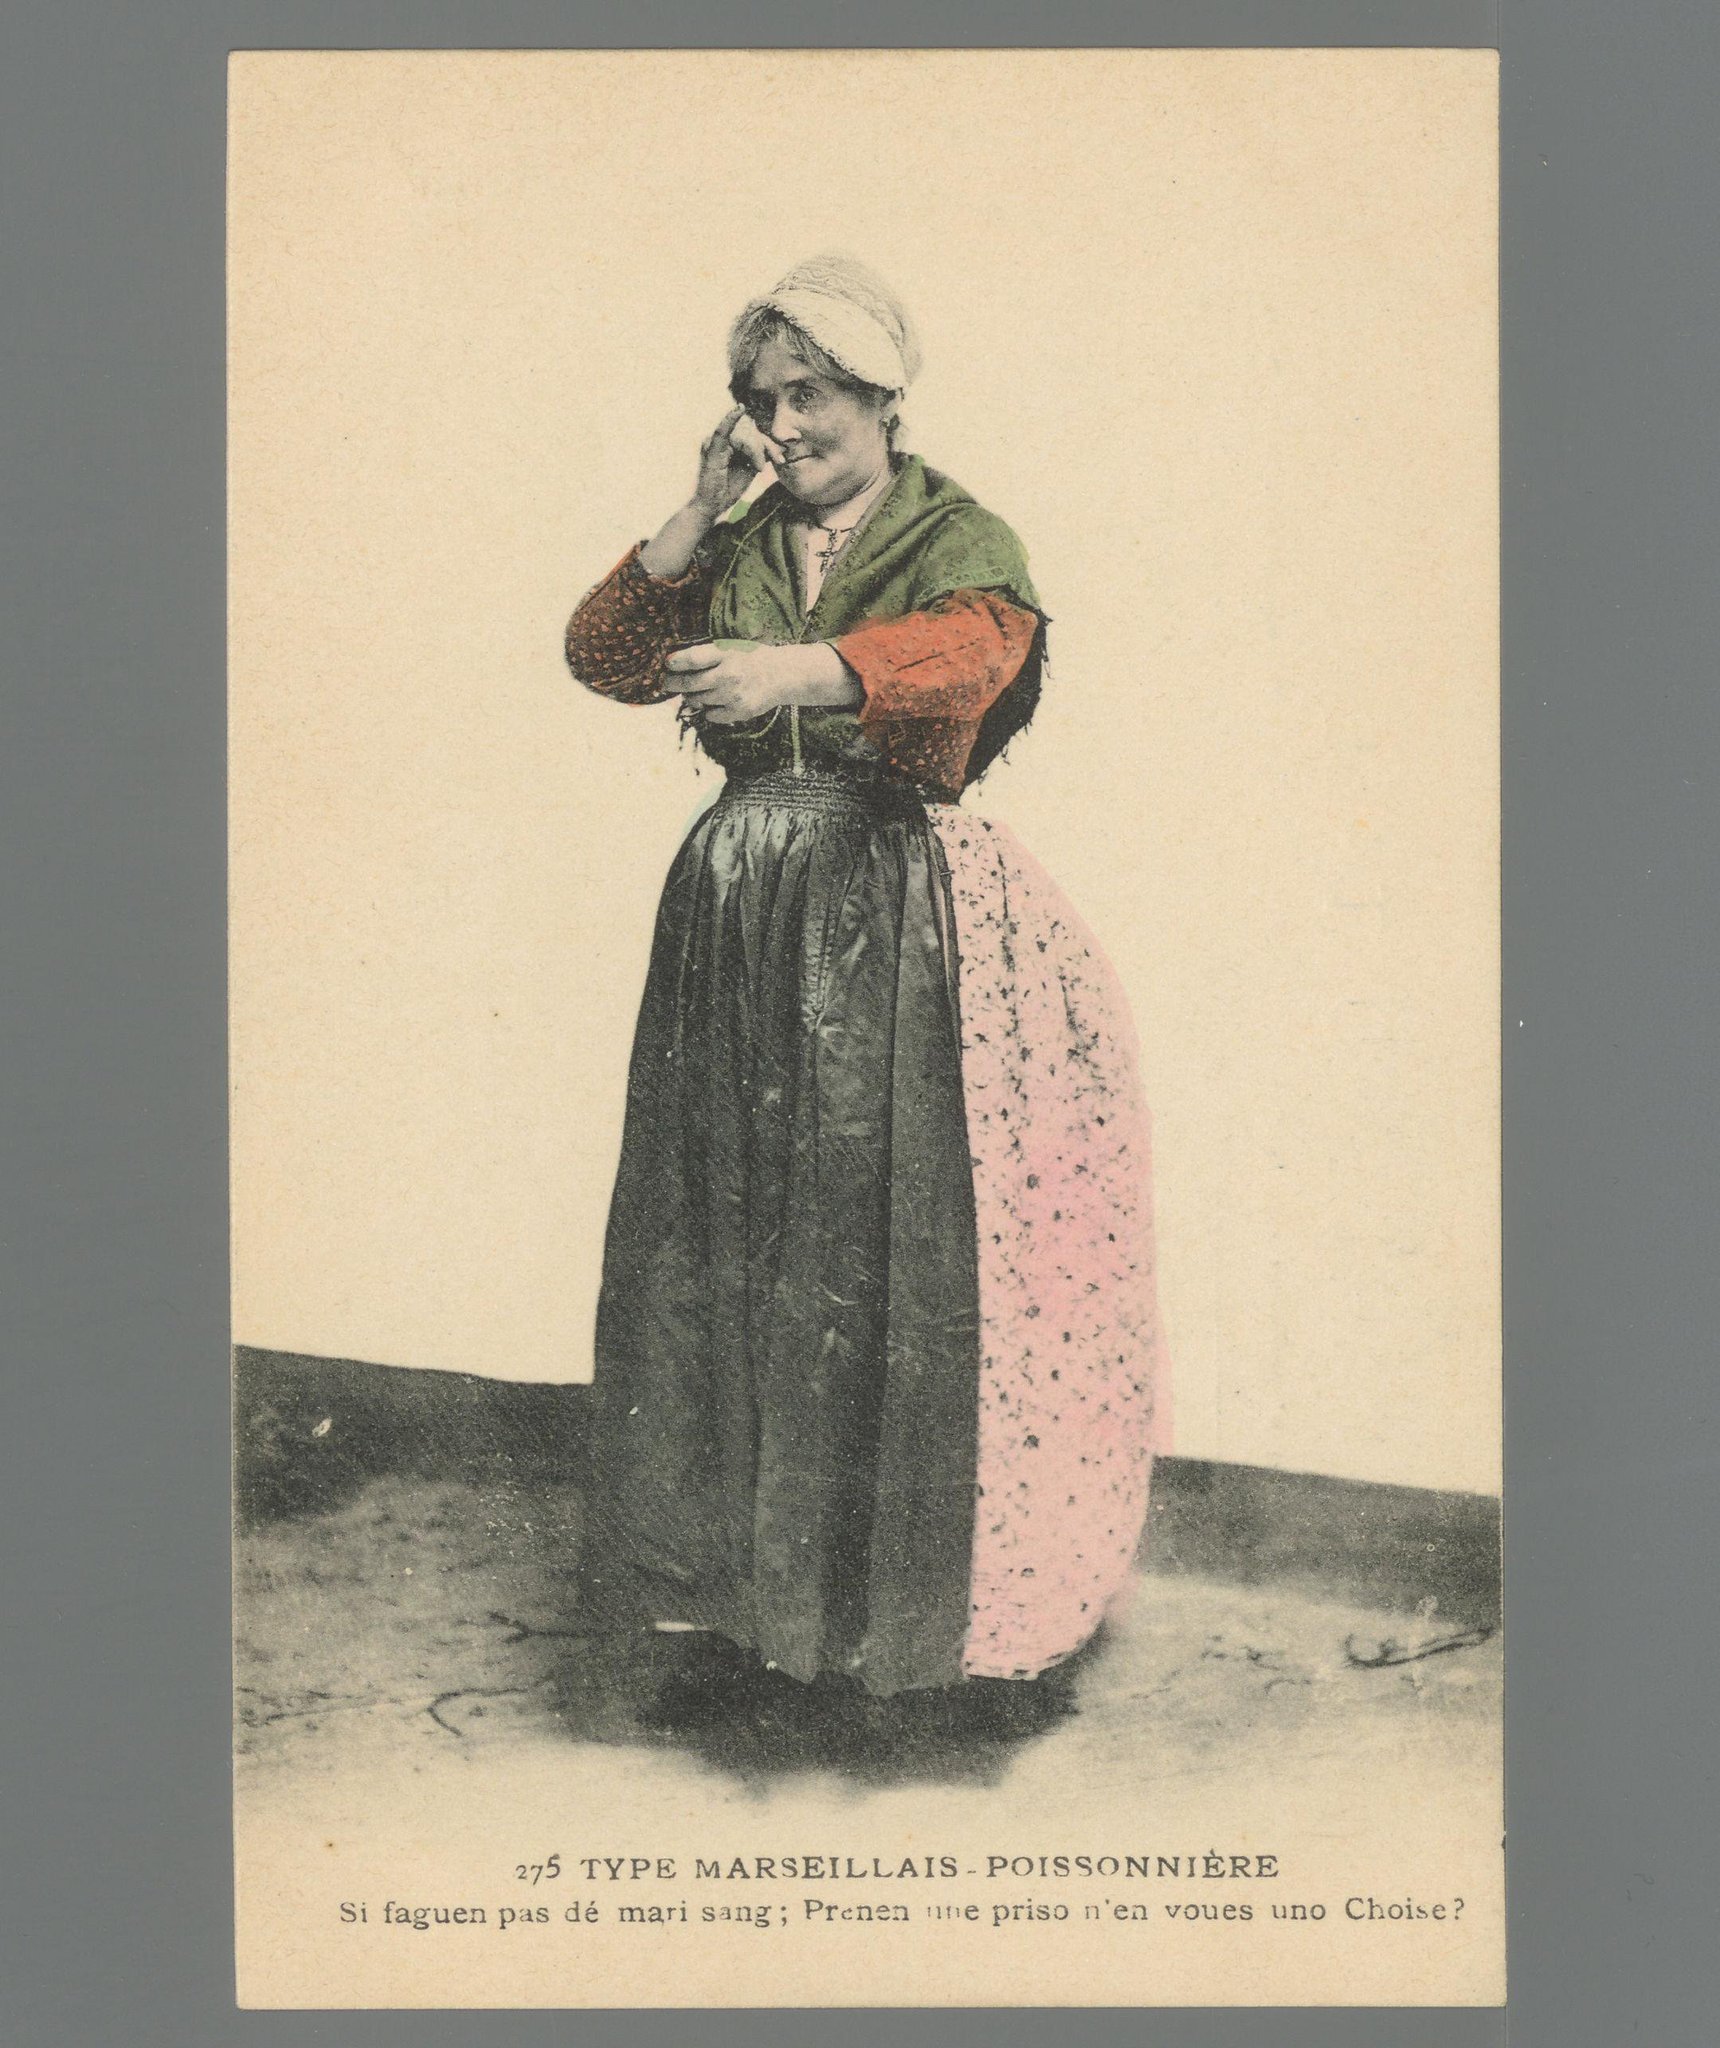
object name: ansichtkaart, prentbriefkaart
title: Type Marseillais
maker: Anonymous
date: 1904-1906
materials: cardboard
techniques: photograph, hand coloring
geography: marseille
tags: adult woman, persons engaged in trade and commerce, sea and coastal fishery, marseille